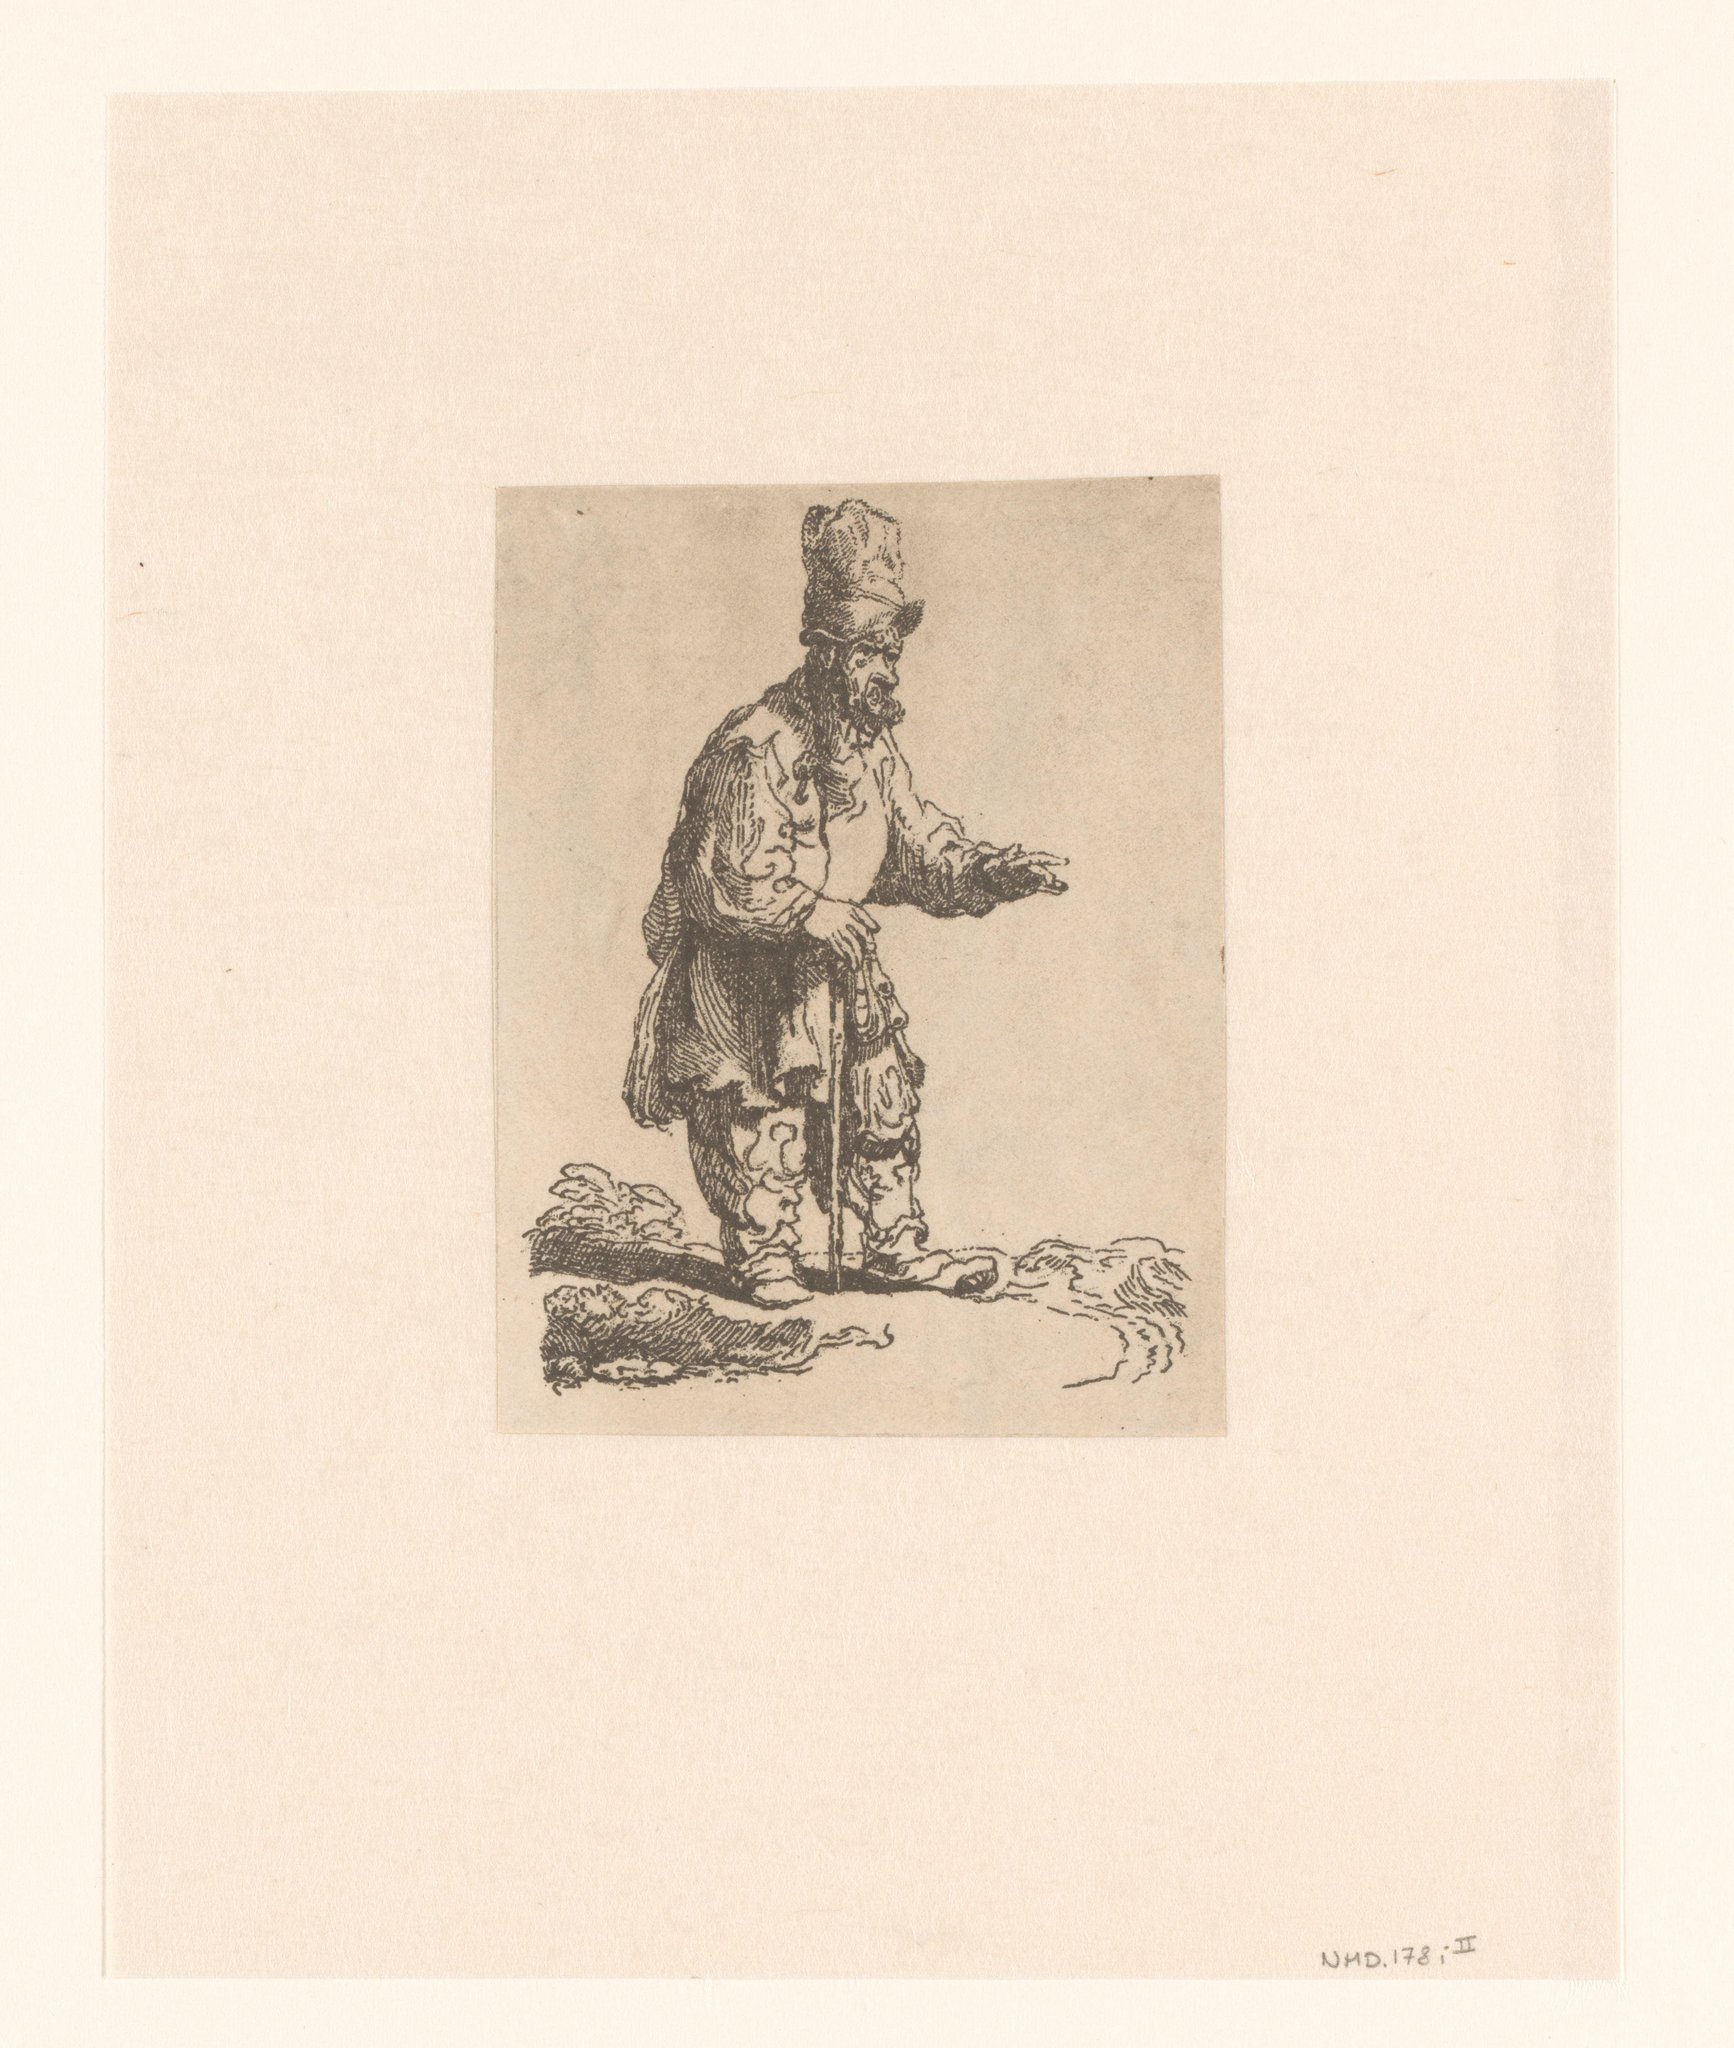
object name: print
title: A peasant in a high cap, standing leaning on a stick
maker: Anonymous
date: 1719-1780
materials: paper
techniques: lithograph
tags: farmers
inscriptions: collector's mark: ‘18’, collector's mark: Lugt 2228, collector's mark: Lugt 2760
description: Prent afgesneden van een blad met zes kopieën naar gelijknamige prenten van Rembrandt, naar voorbeeld van kopieën van Vivaris.